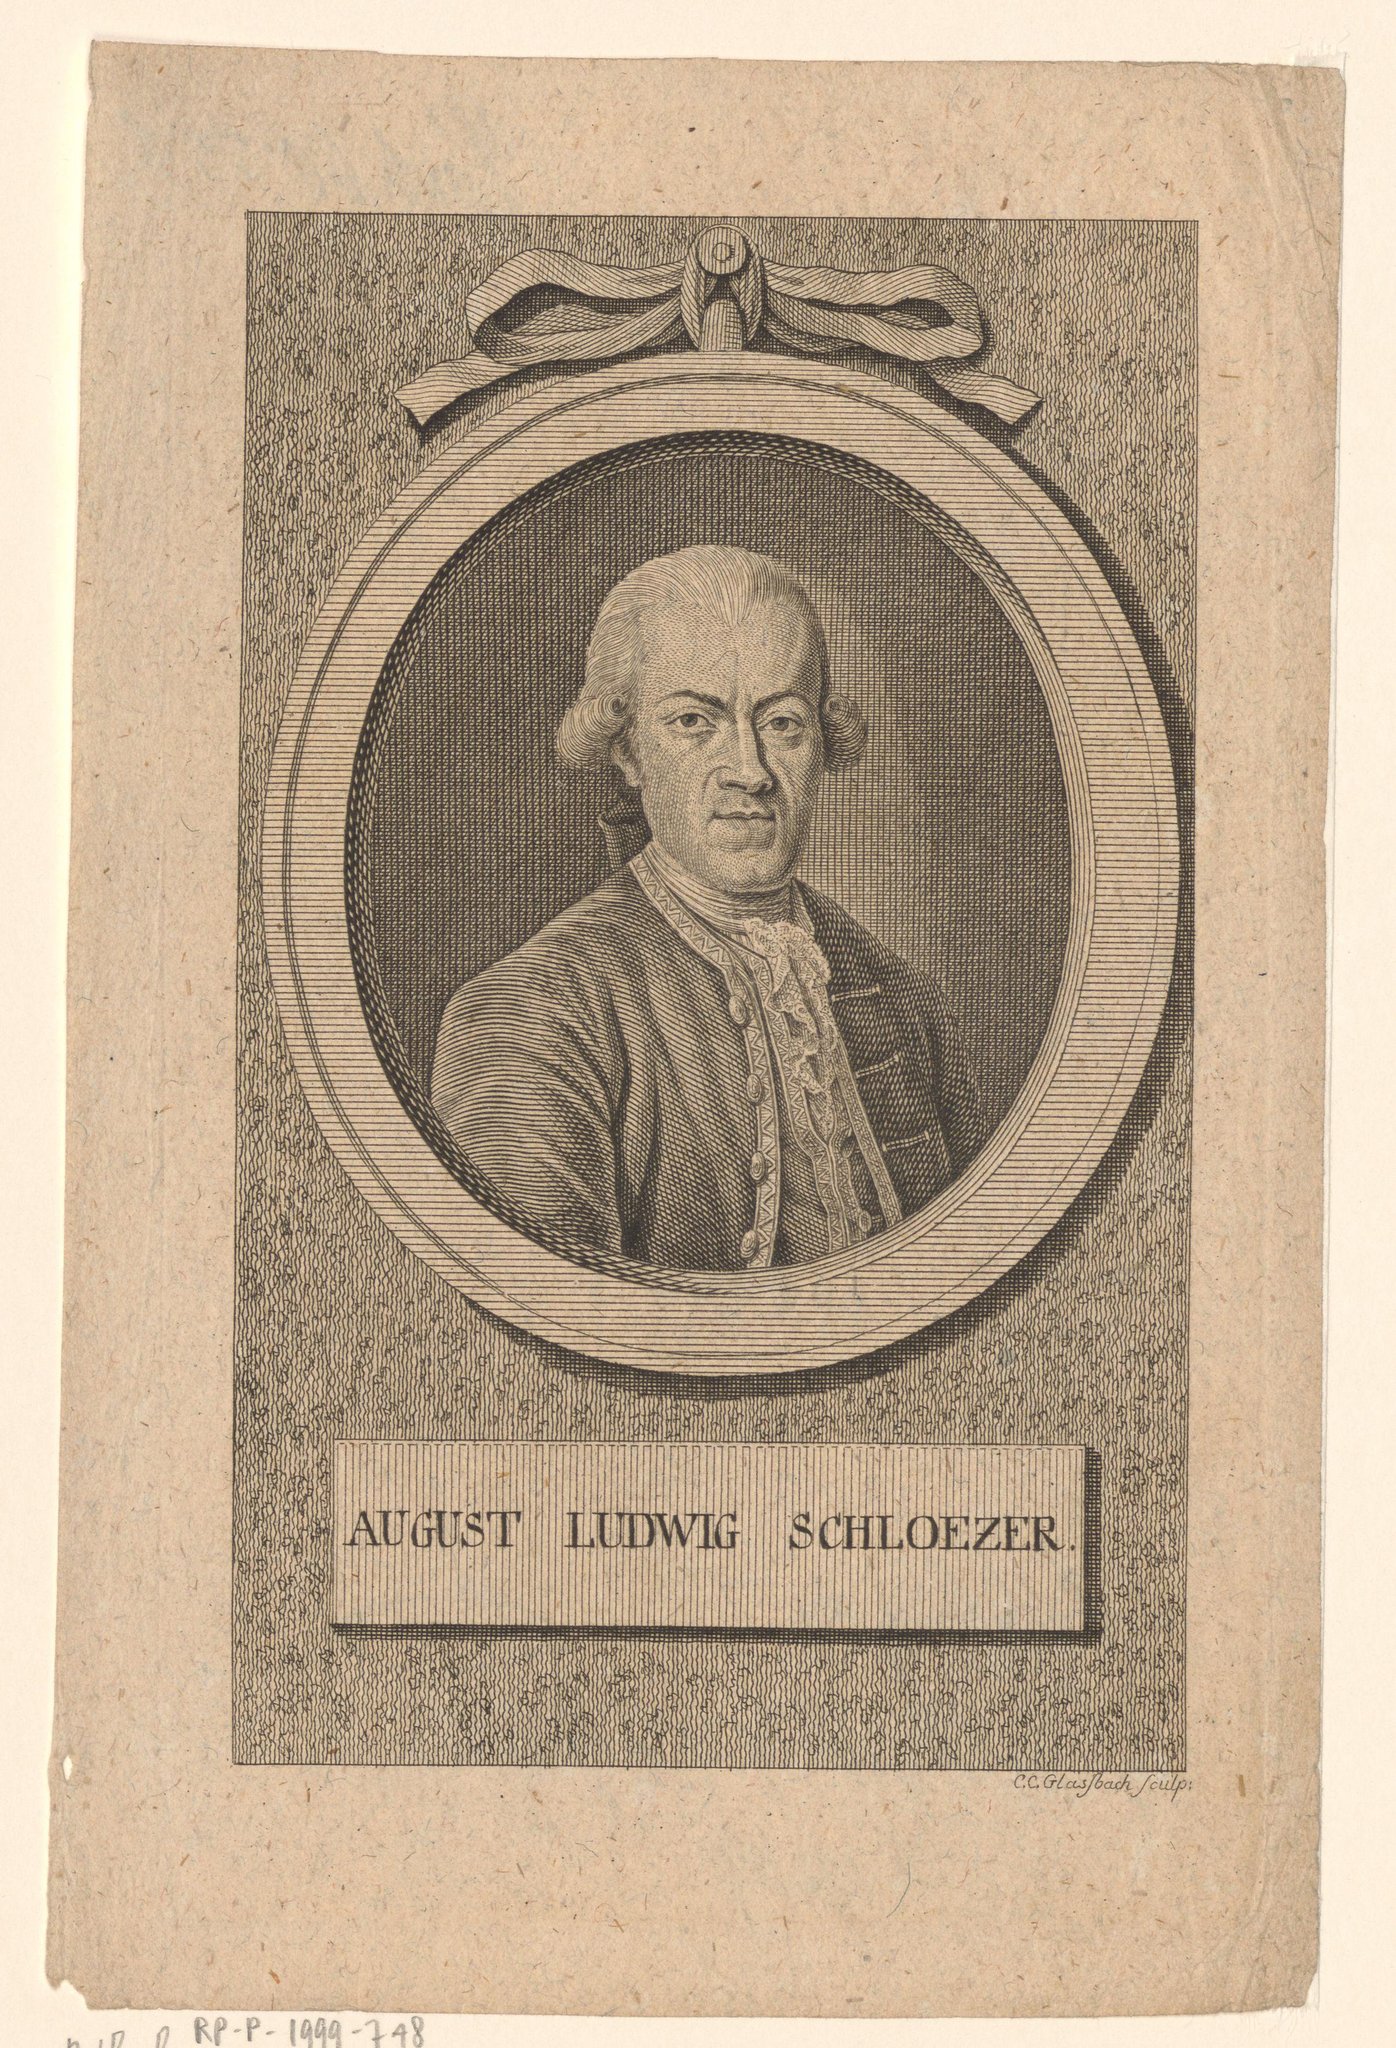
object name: print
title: Portret van August Ludwig von Schlözer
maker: carl christian glassbach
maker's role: print maker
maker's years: 1751-1789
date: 1780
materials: paper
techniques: engraving, etching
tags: scholar, philosopher, historical persons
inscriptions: collector's mark: Lugt 2228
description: Portret van de historicus August Ludwig (1802 von) Schlözer (1735-1809). Buste naar rechts, in ronde lijst met strik bovenaan.